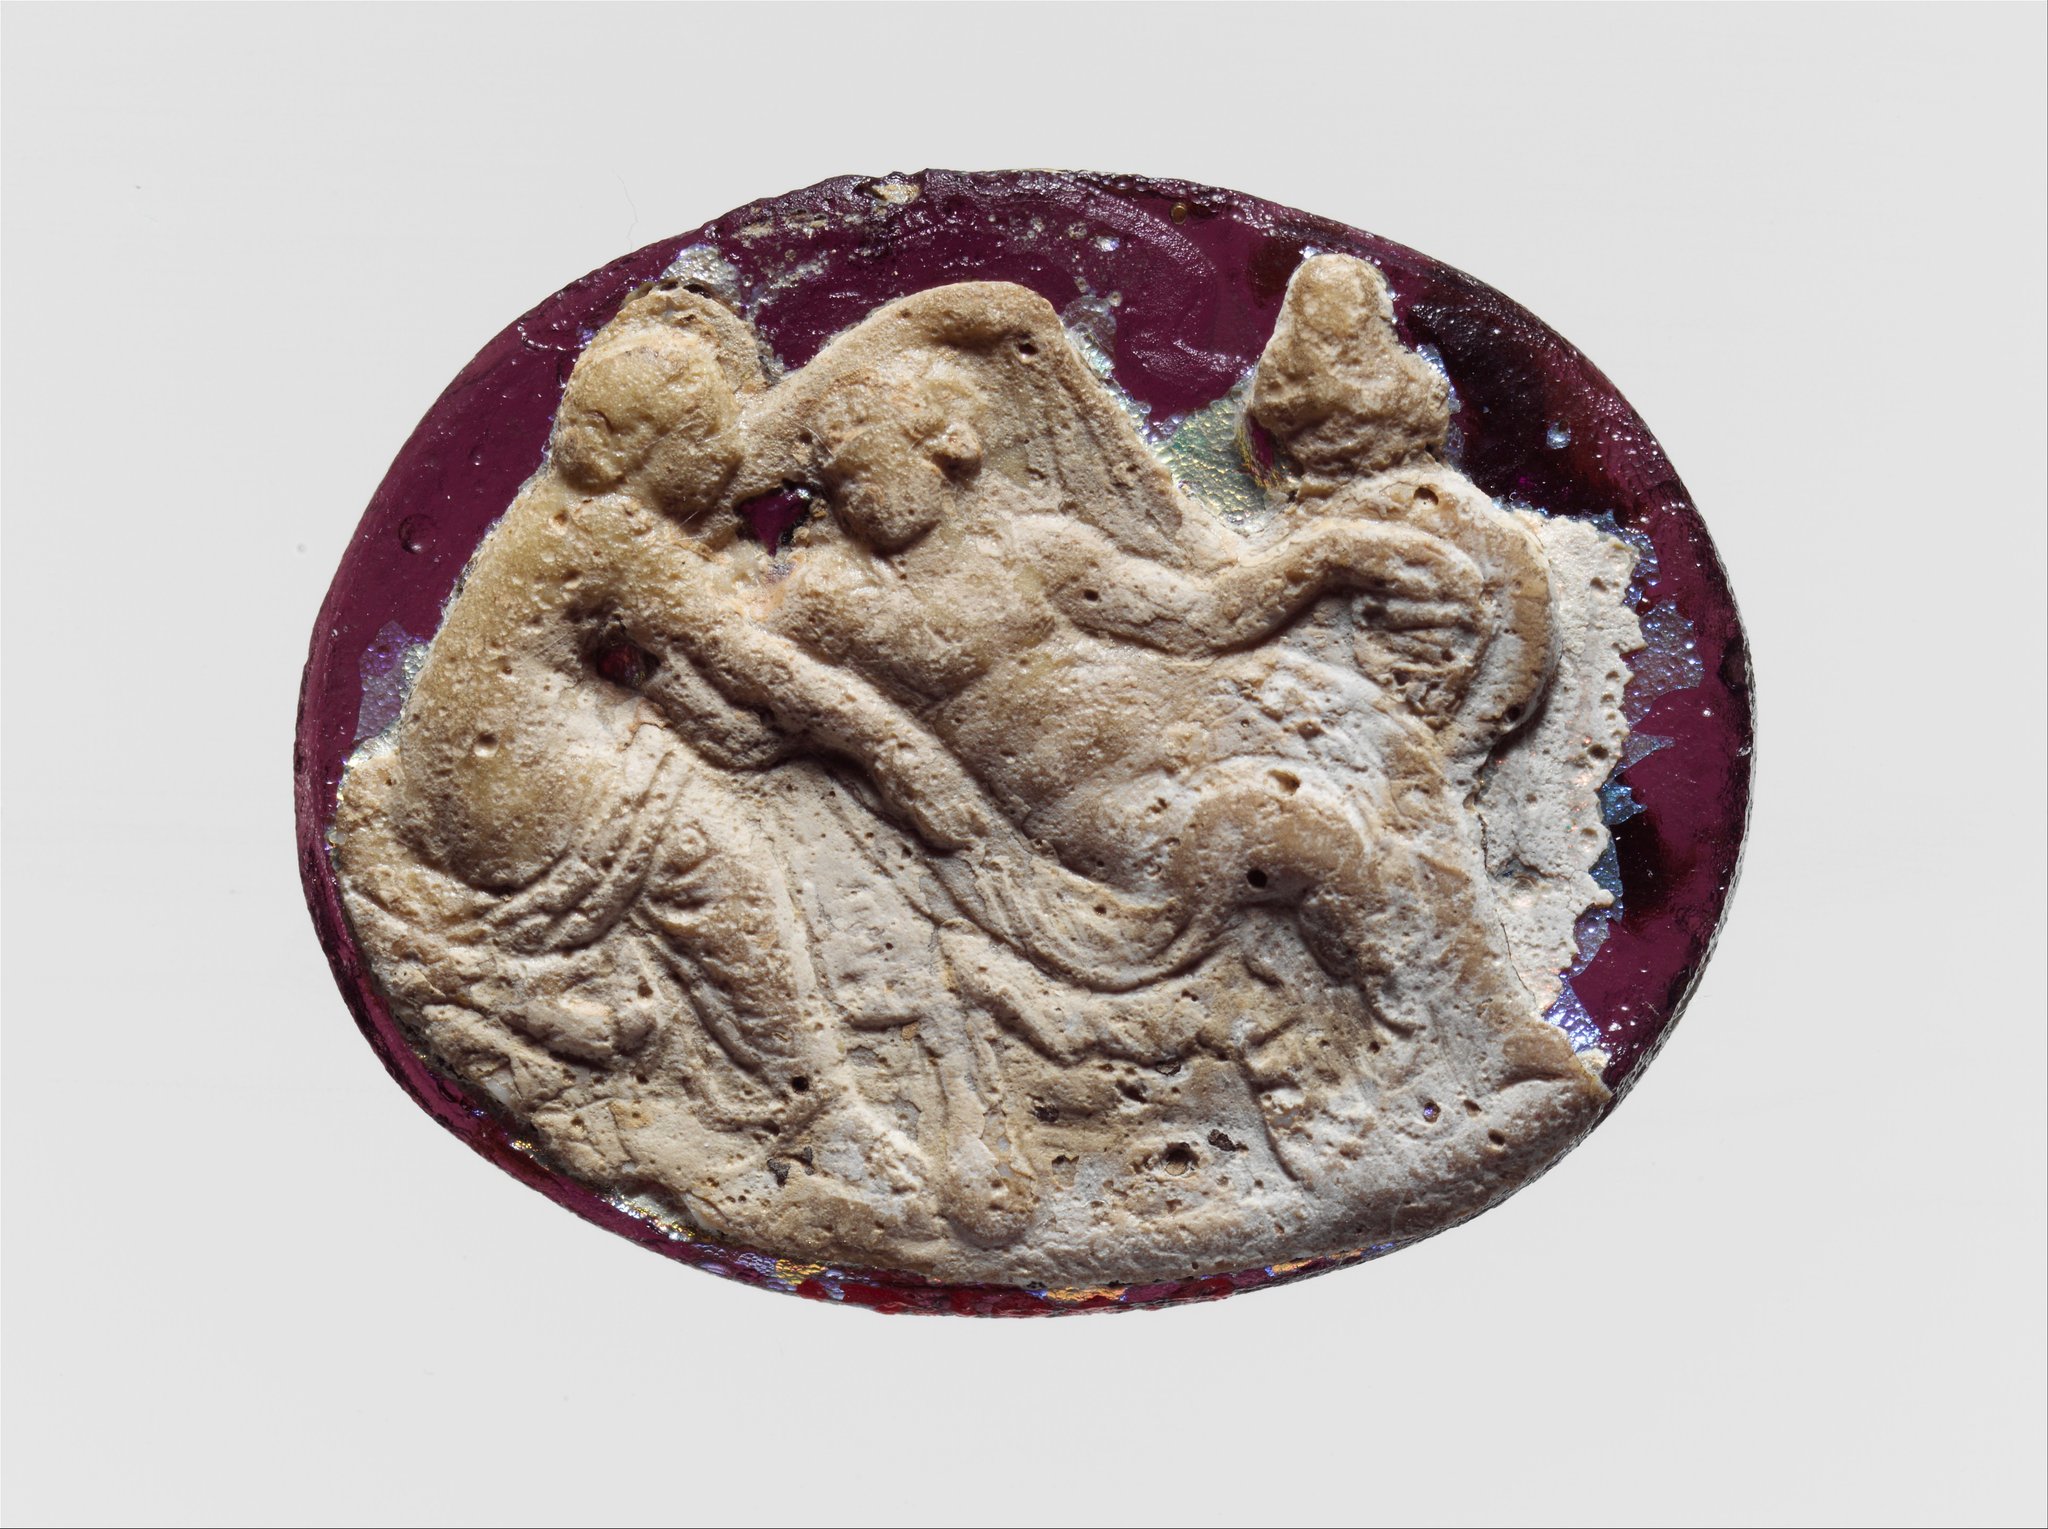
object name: cameo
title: Glass cameo: Dionysos and a nymph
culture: roman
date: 100 BCE-300 CE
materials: glass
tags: dionysus,nymphs